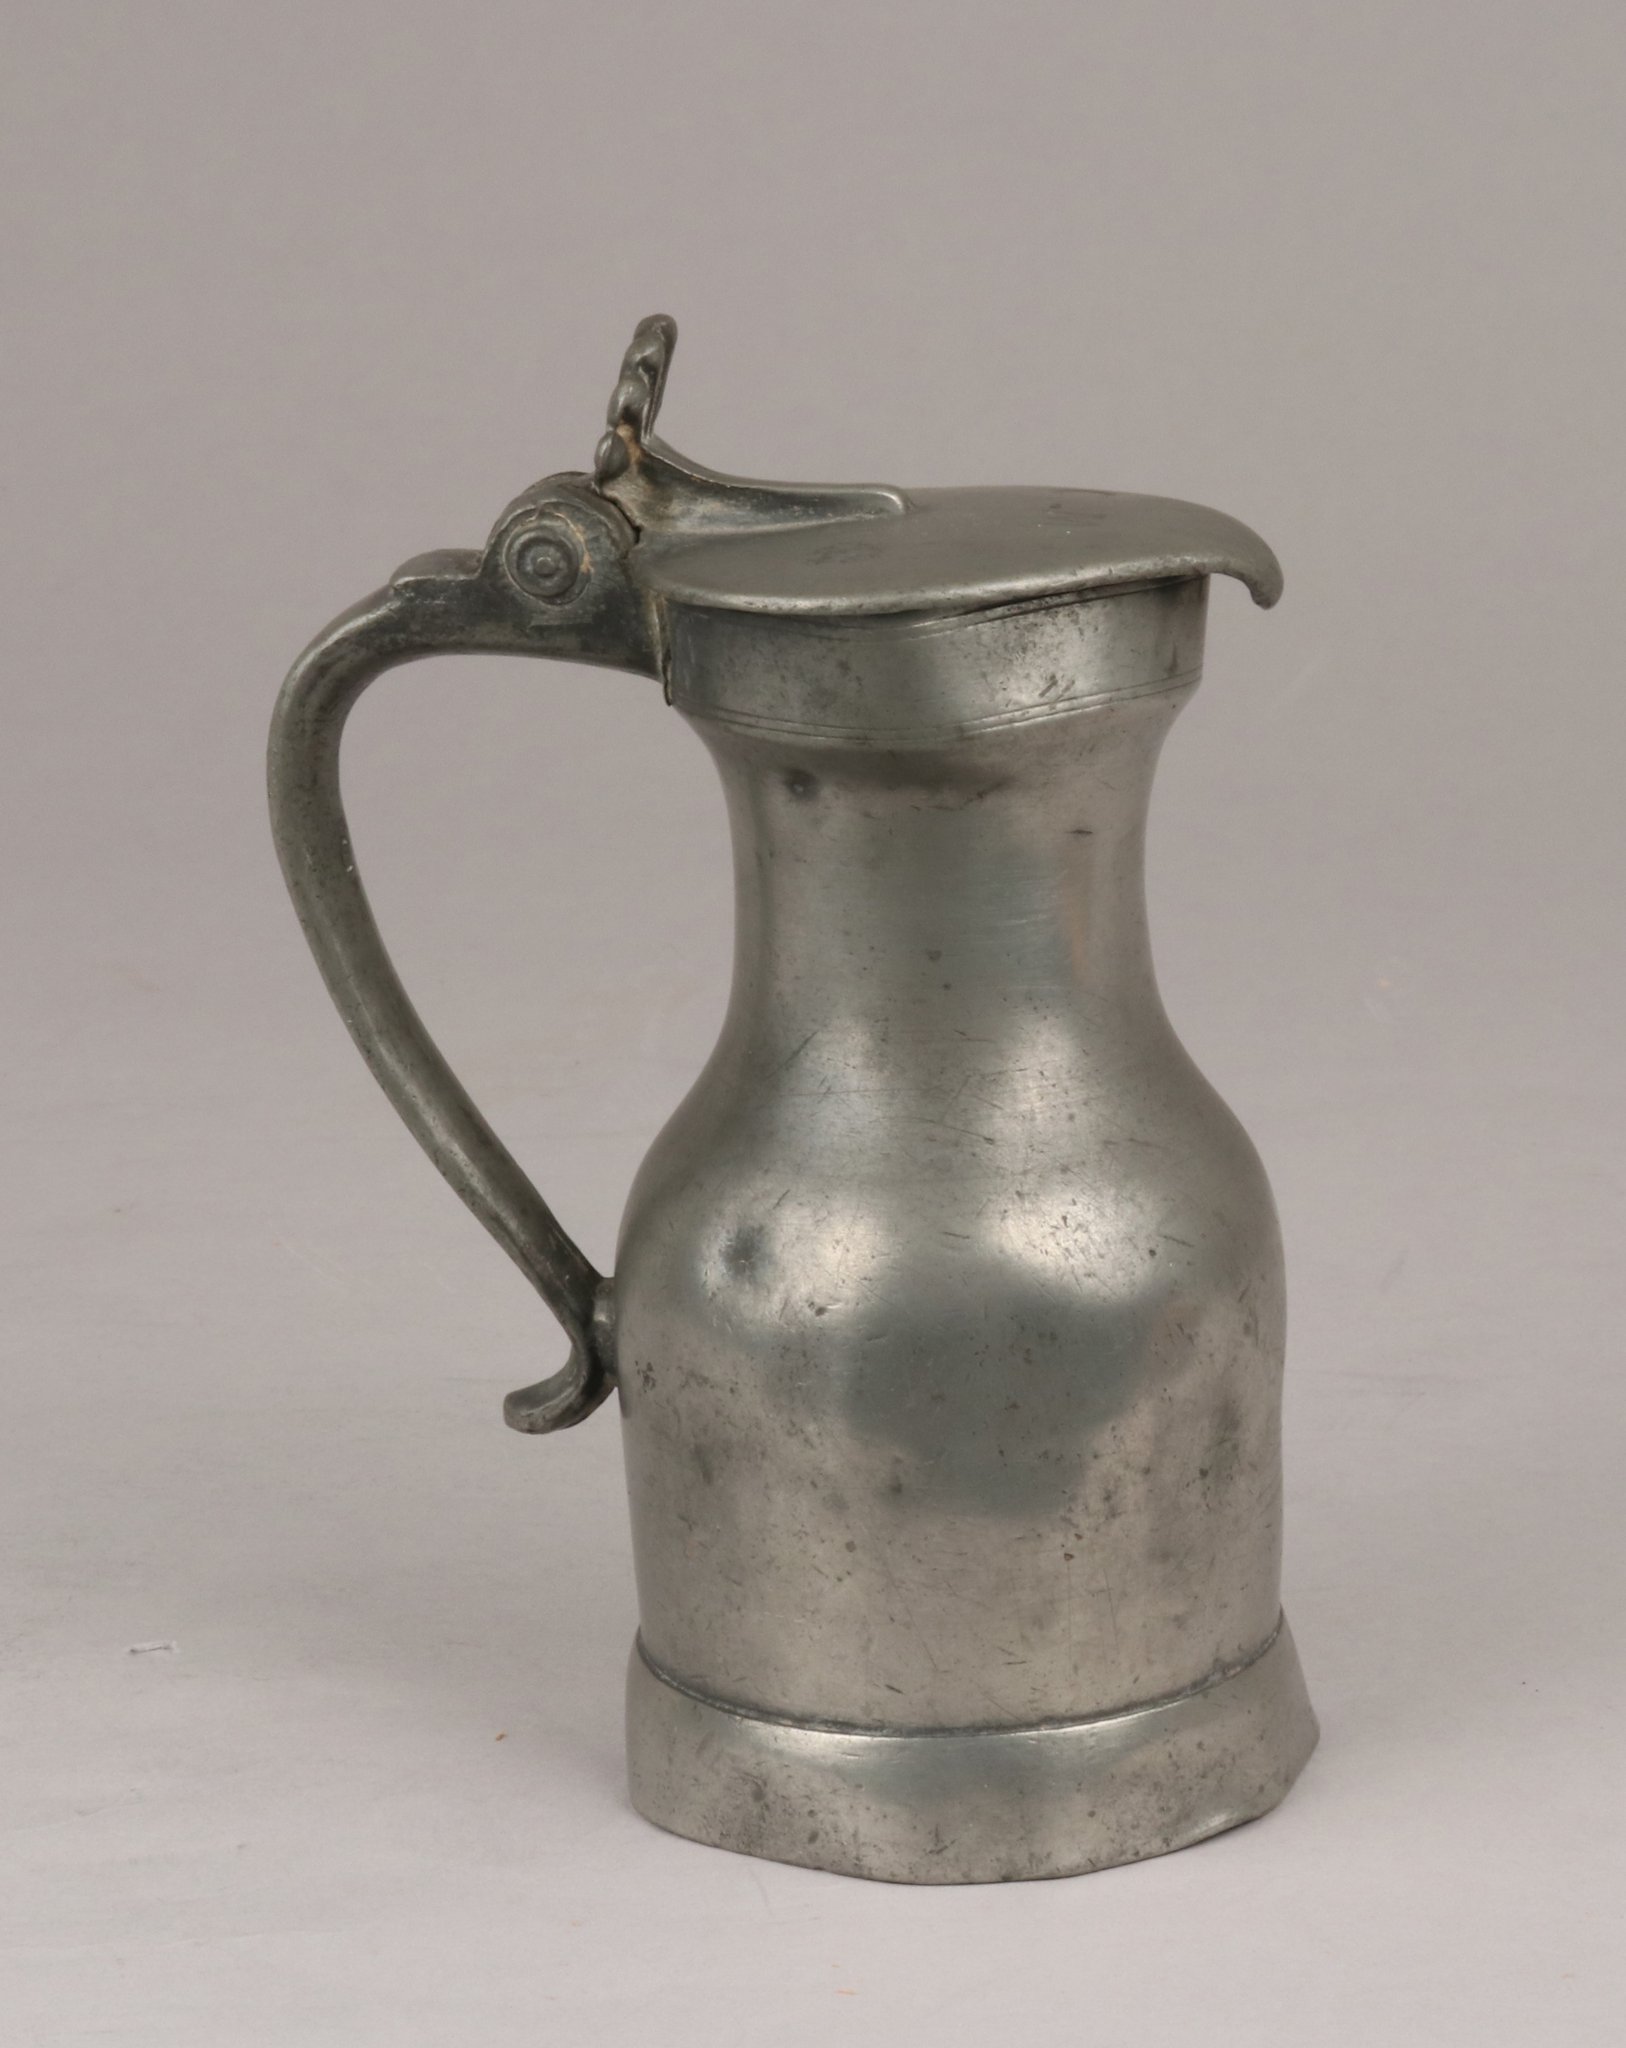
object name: measure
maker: robert toussaint baillard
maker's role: maker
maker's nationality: french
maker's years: 1743-1786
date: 1734-1766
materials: pewter